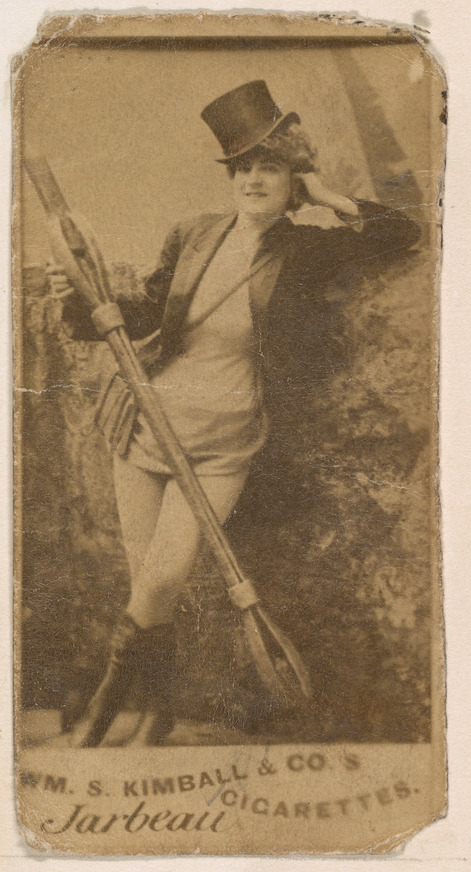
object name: photograph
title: Miss Jarbeau, from the Actresses series (N203) issued by Wm. S. Kimball & Co.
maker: william s. kimball & company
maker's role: publisher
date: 1889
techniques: color lithograph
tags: portraits,women,actresses